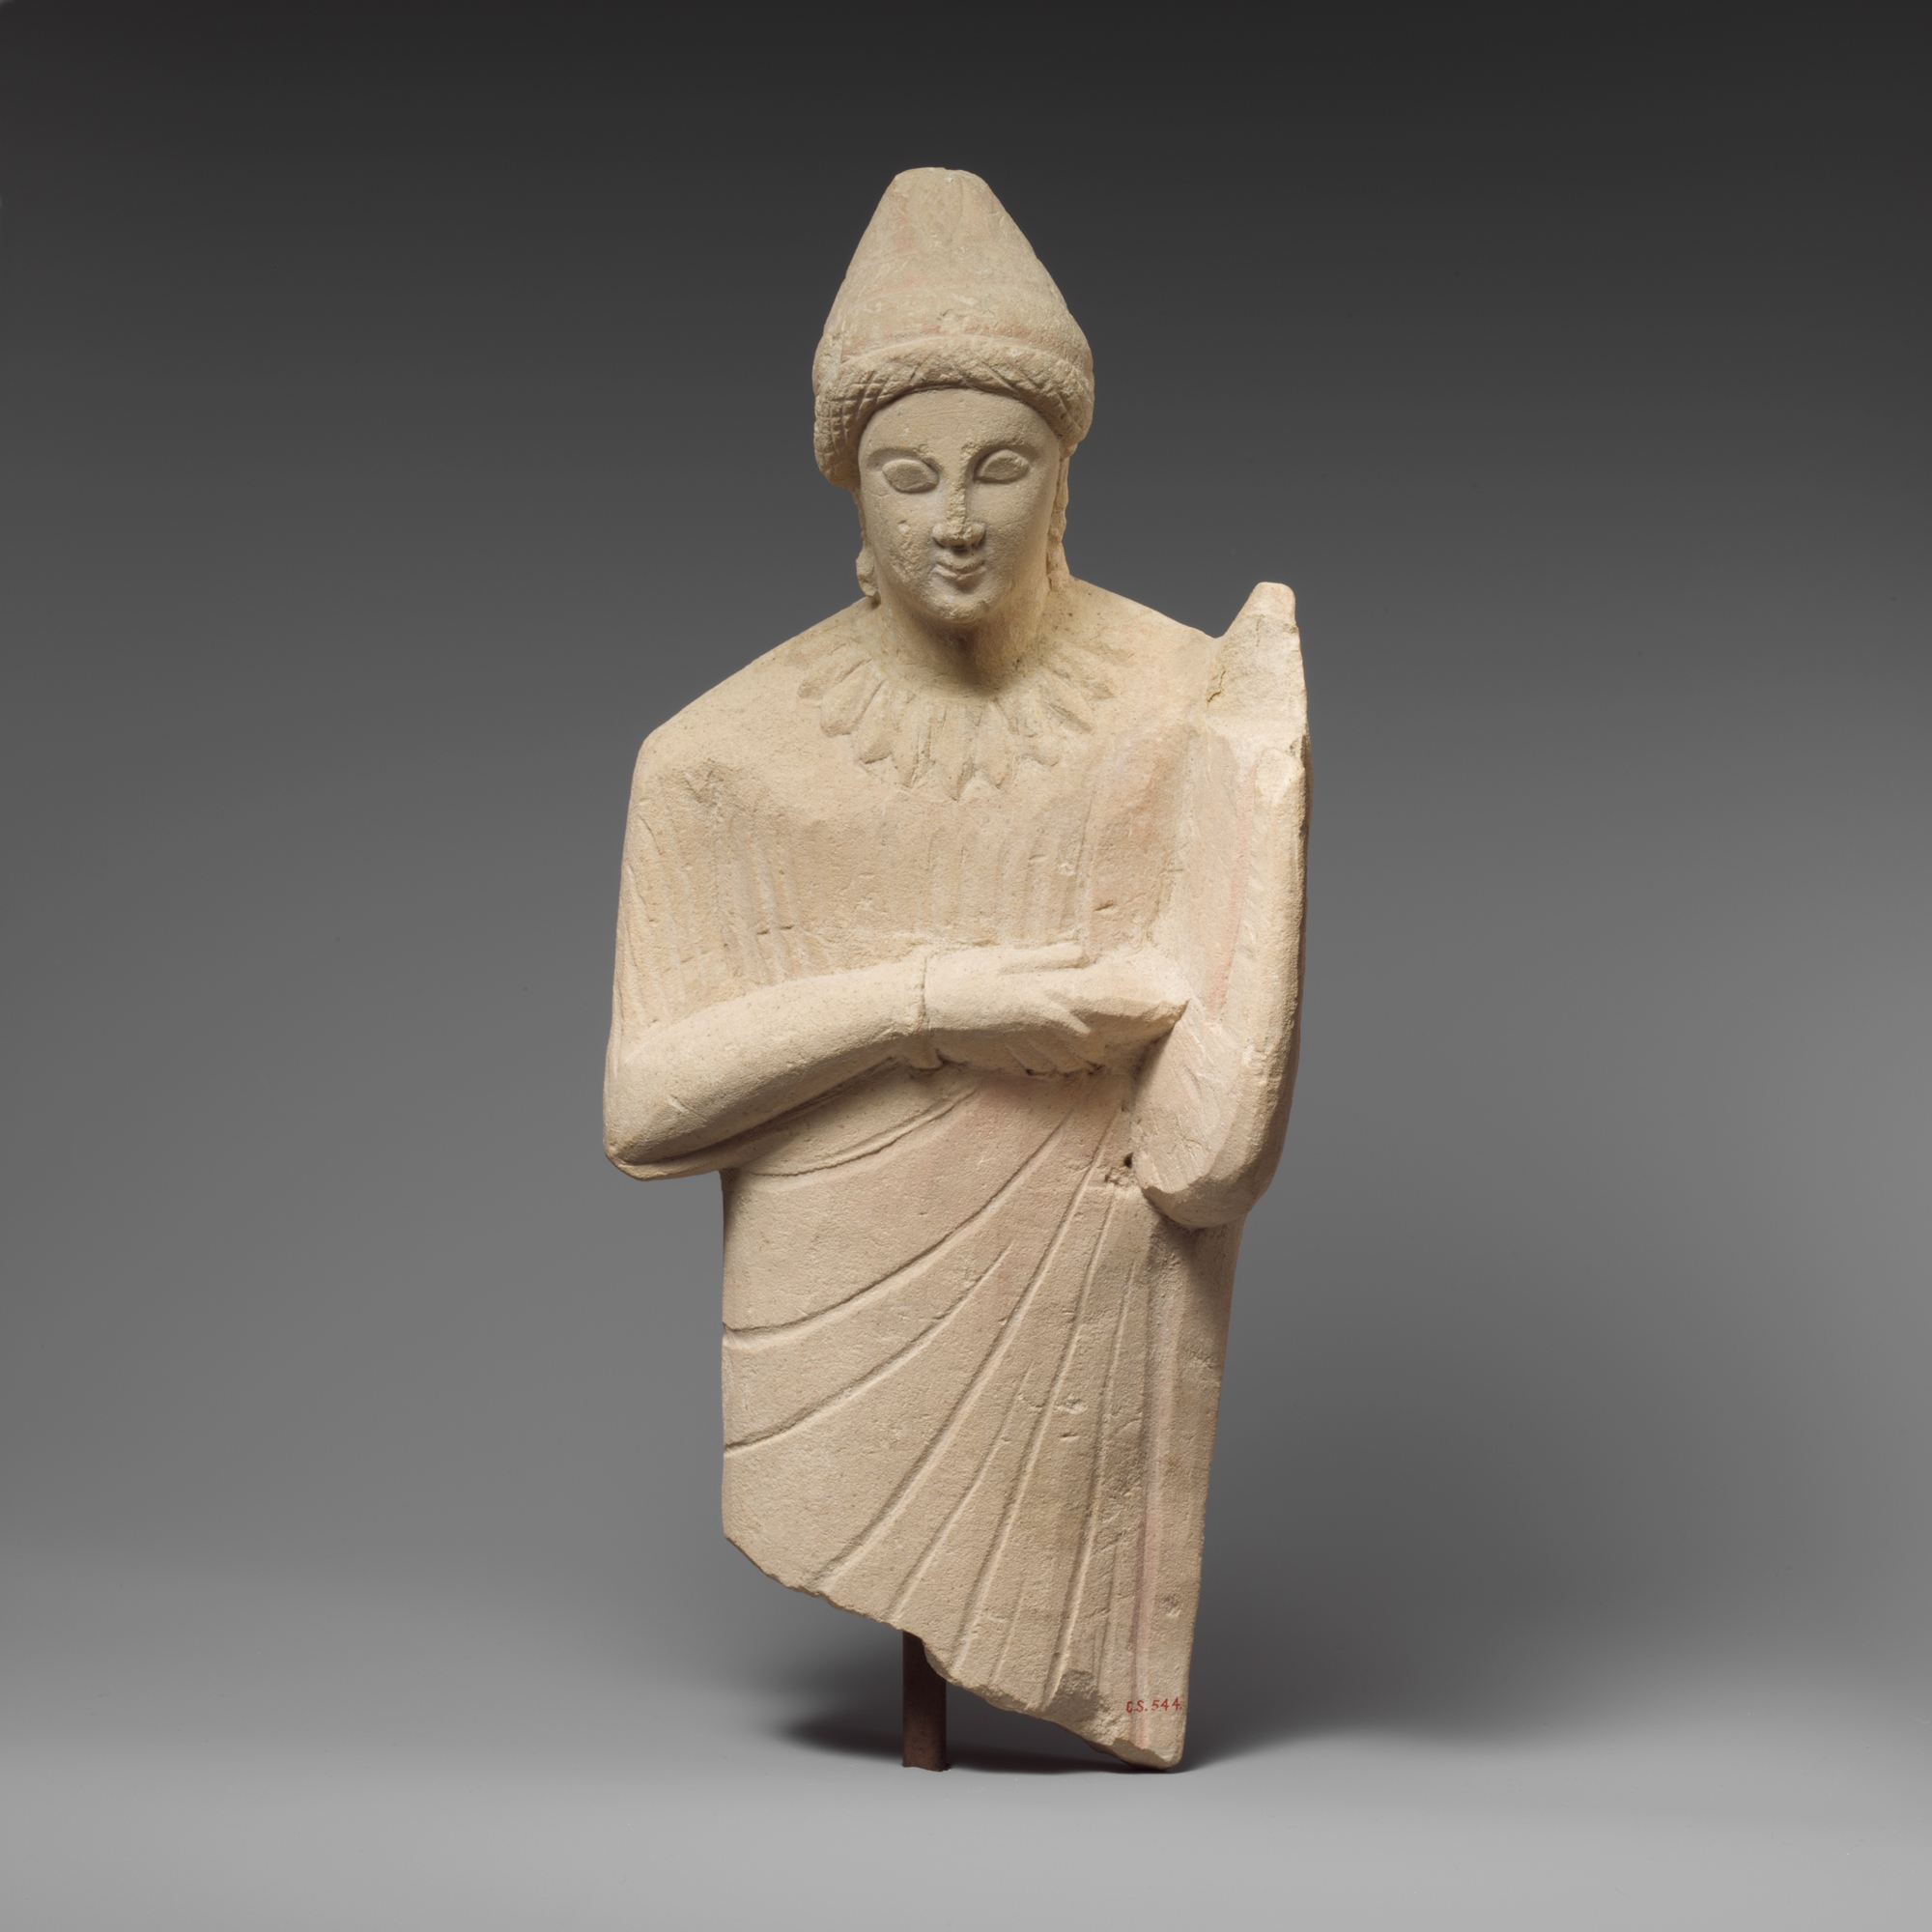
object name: statue of a lyre player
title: Limestone statuette of a female lyre player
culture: cypriot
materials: limestone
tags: musical instruments,necklaces,women,musicians